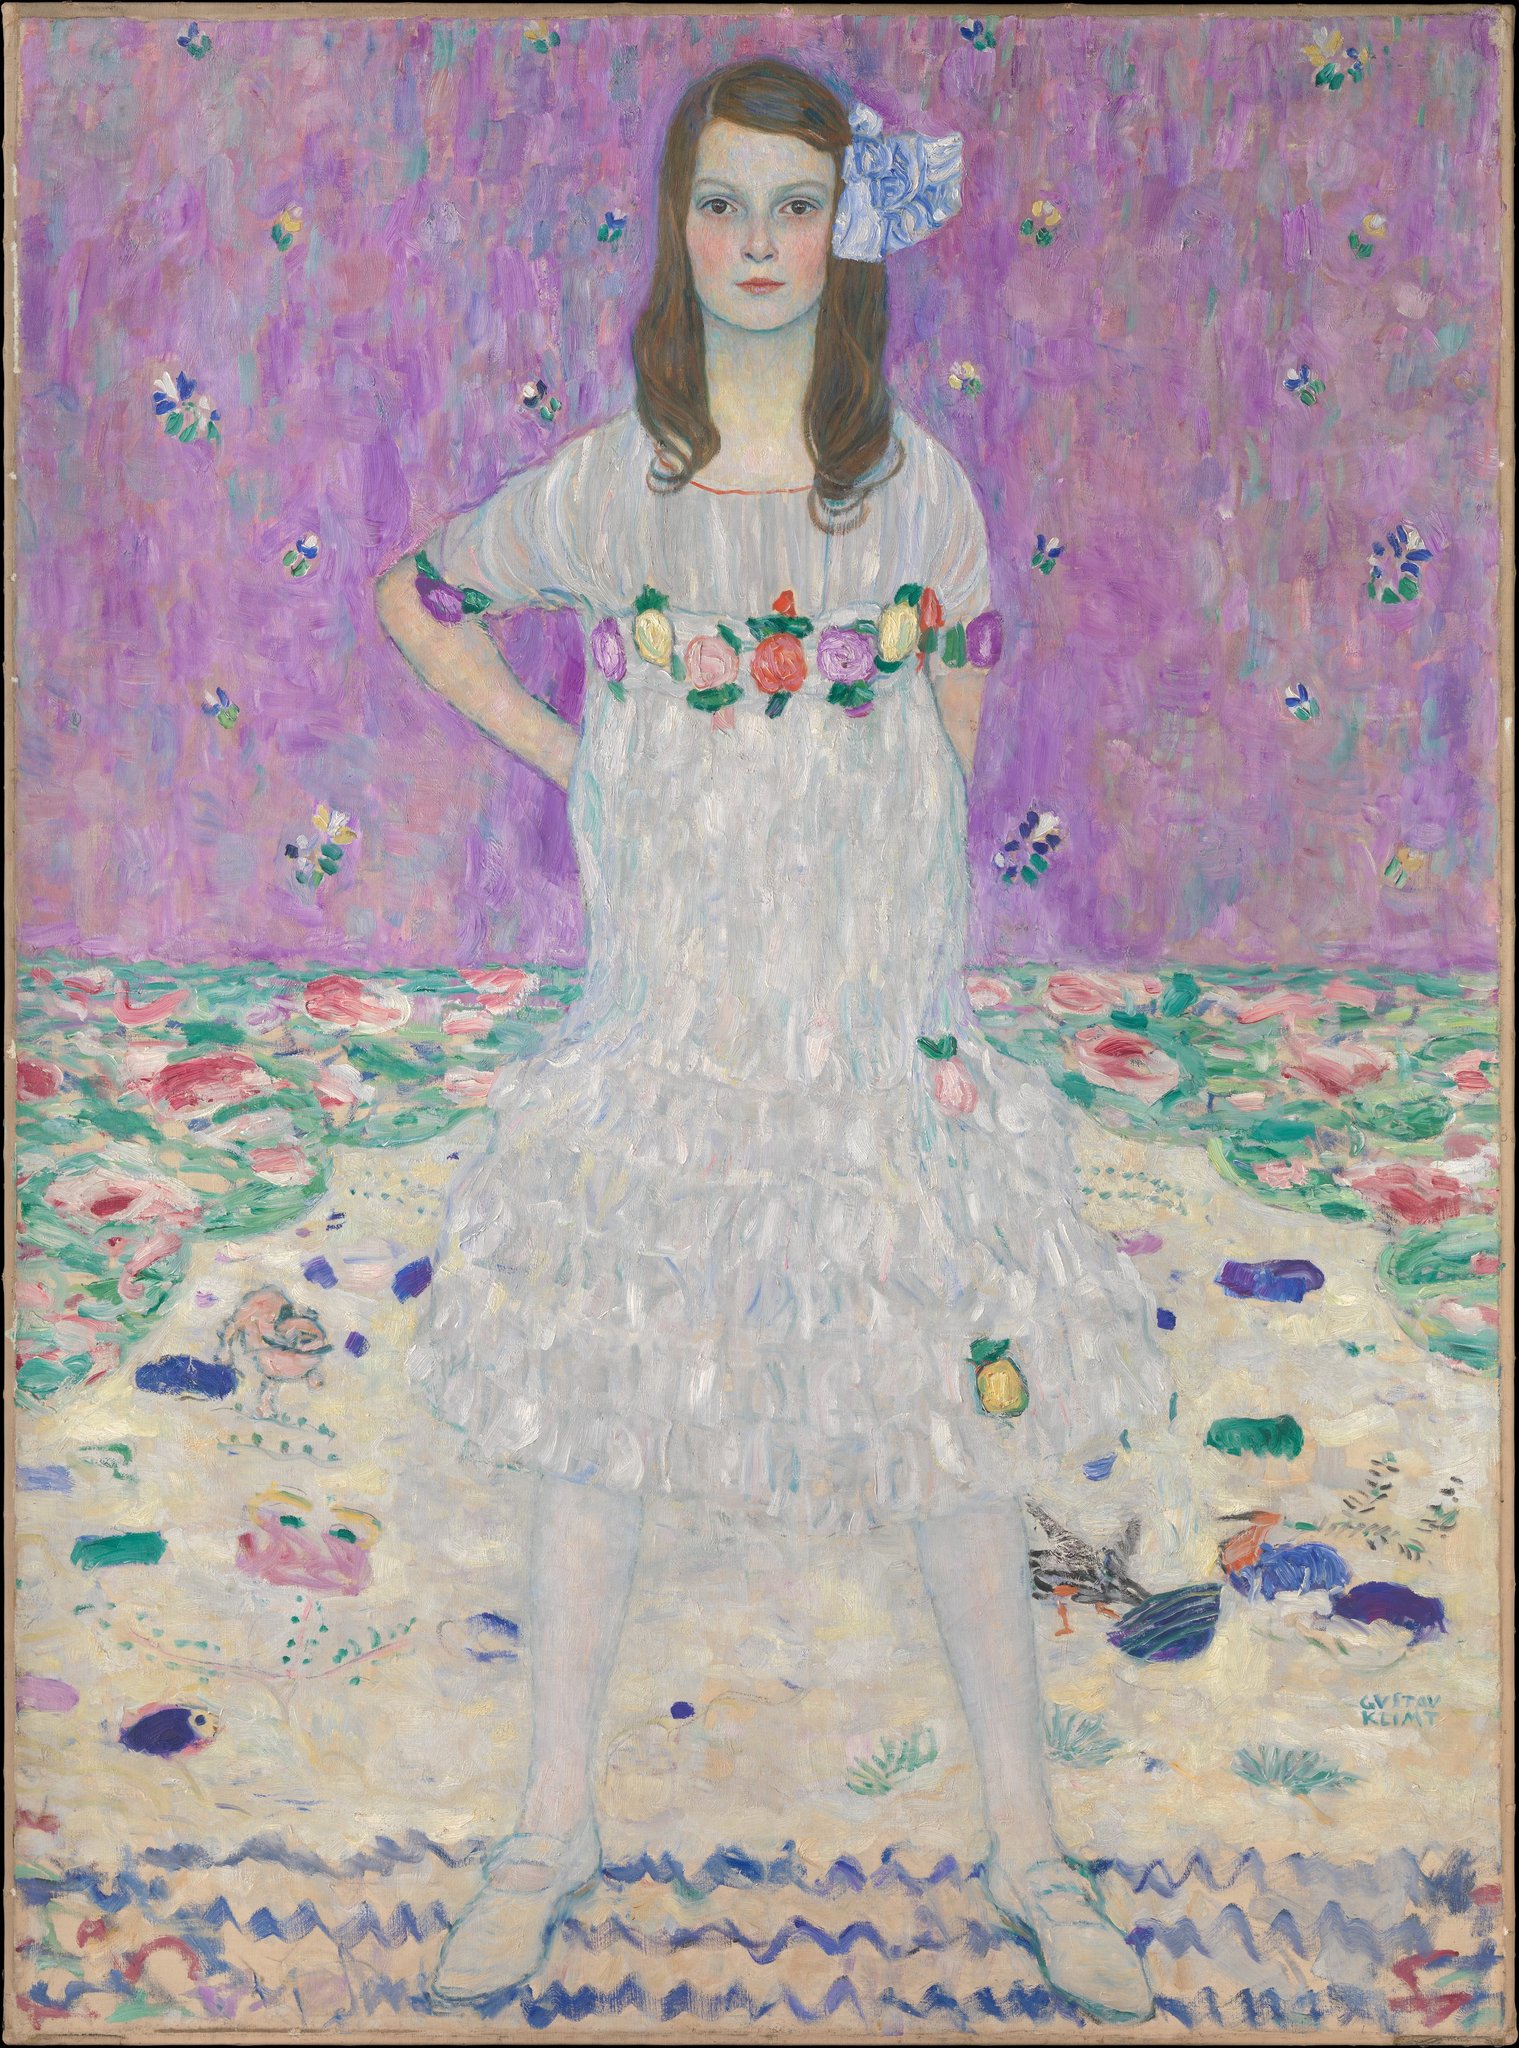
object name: painting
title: Mäda Primavesi (1903–2000)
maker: gustav klimt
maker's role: artist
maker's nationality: austrian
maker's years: 1862-1918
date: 1912-1913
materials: canvas, oil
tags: girls,portraits